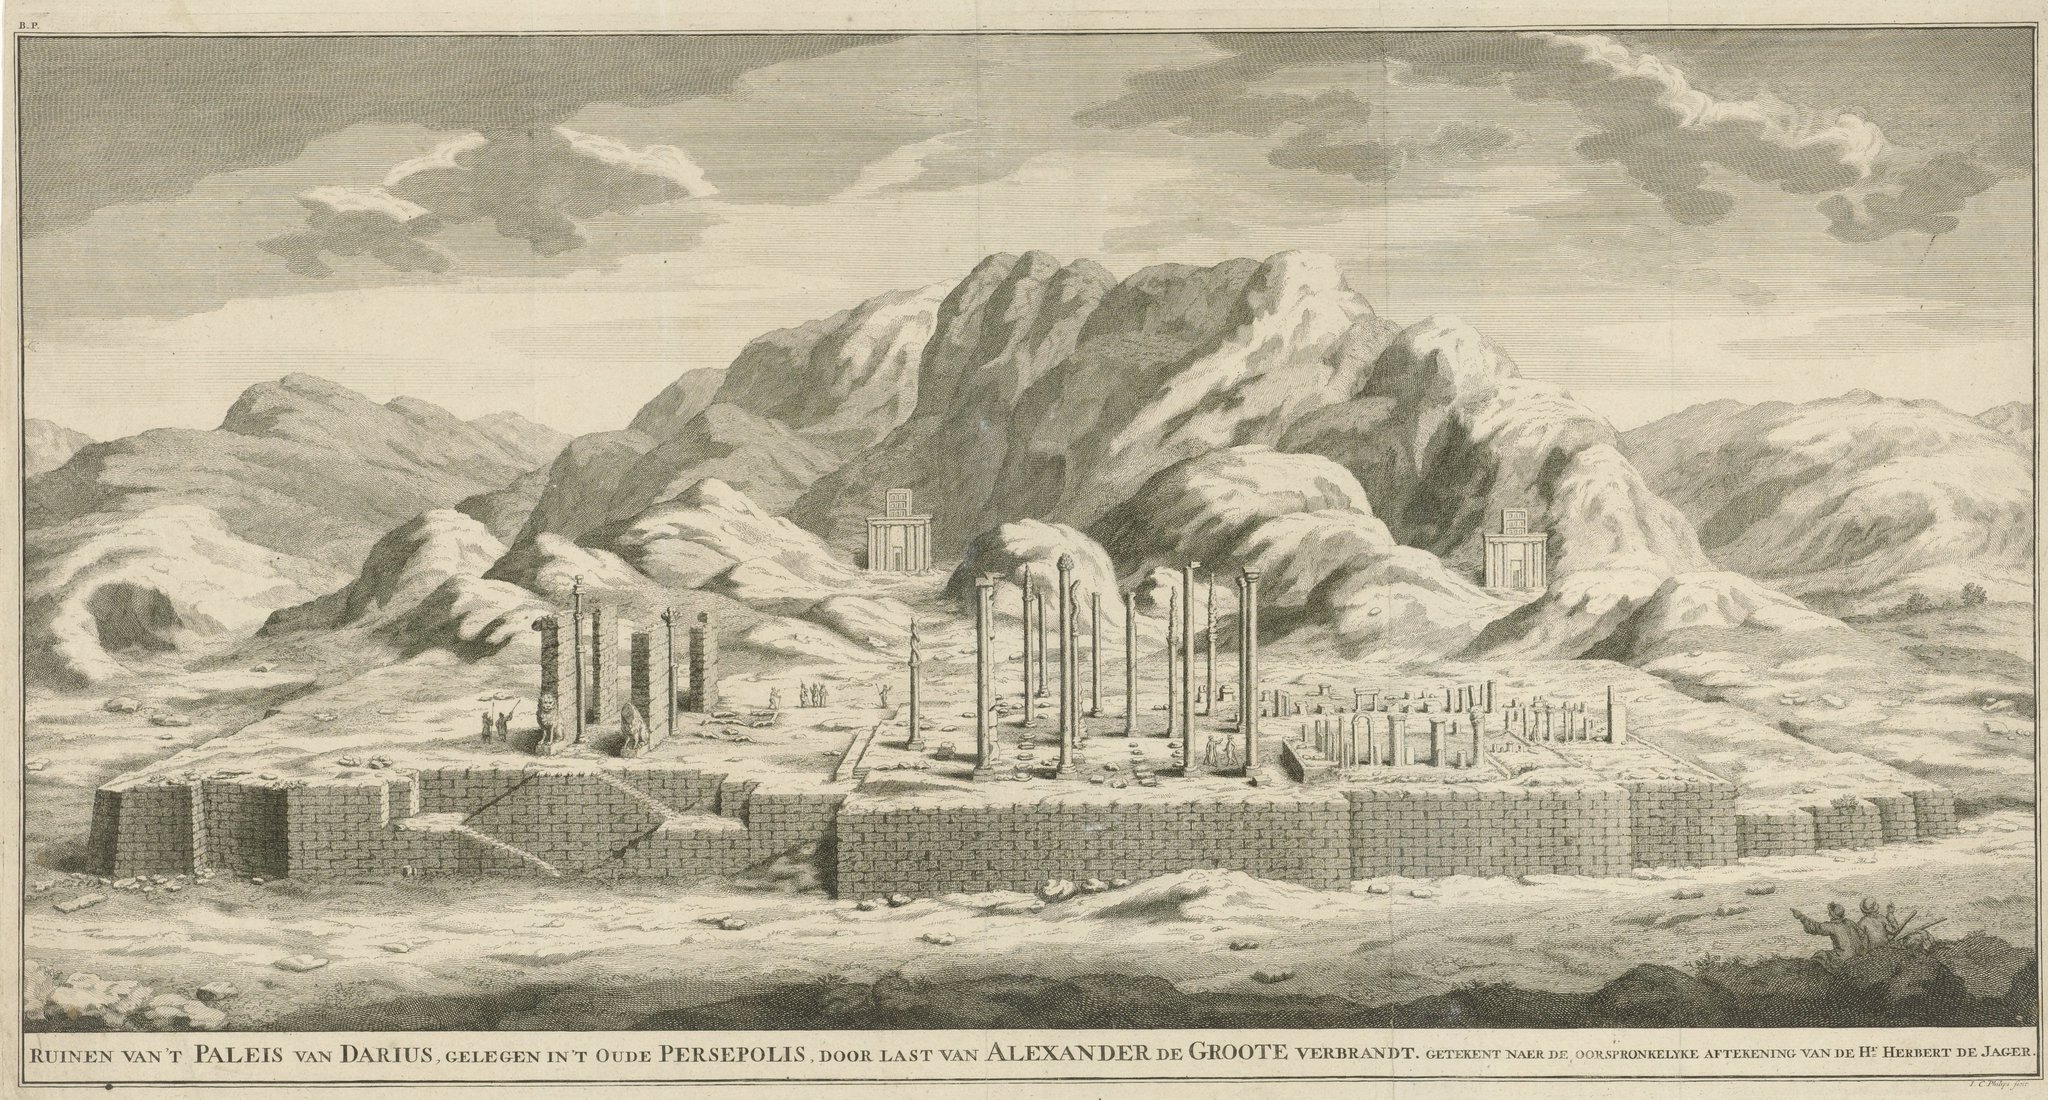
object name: print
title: Gezicht op de ruïnes van het paleis van de Perzische koning Darius te Persepolis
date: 1736-1775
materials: paper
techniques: etching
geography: amsterdam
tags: landscape with ruins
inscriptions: collector's mark: Lugt 2228